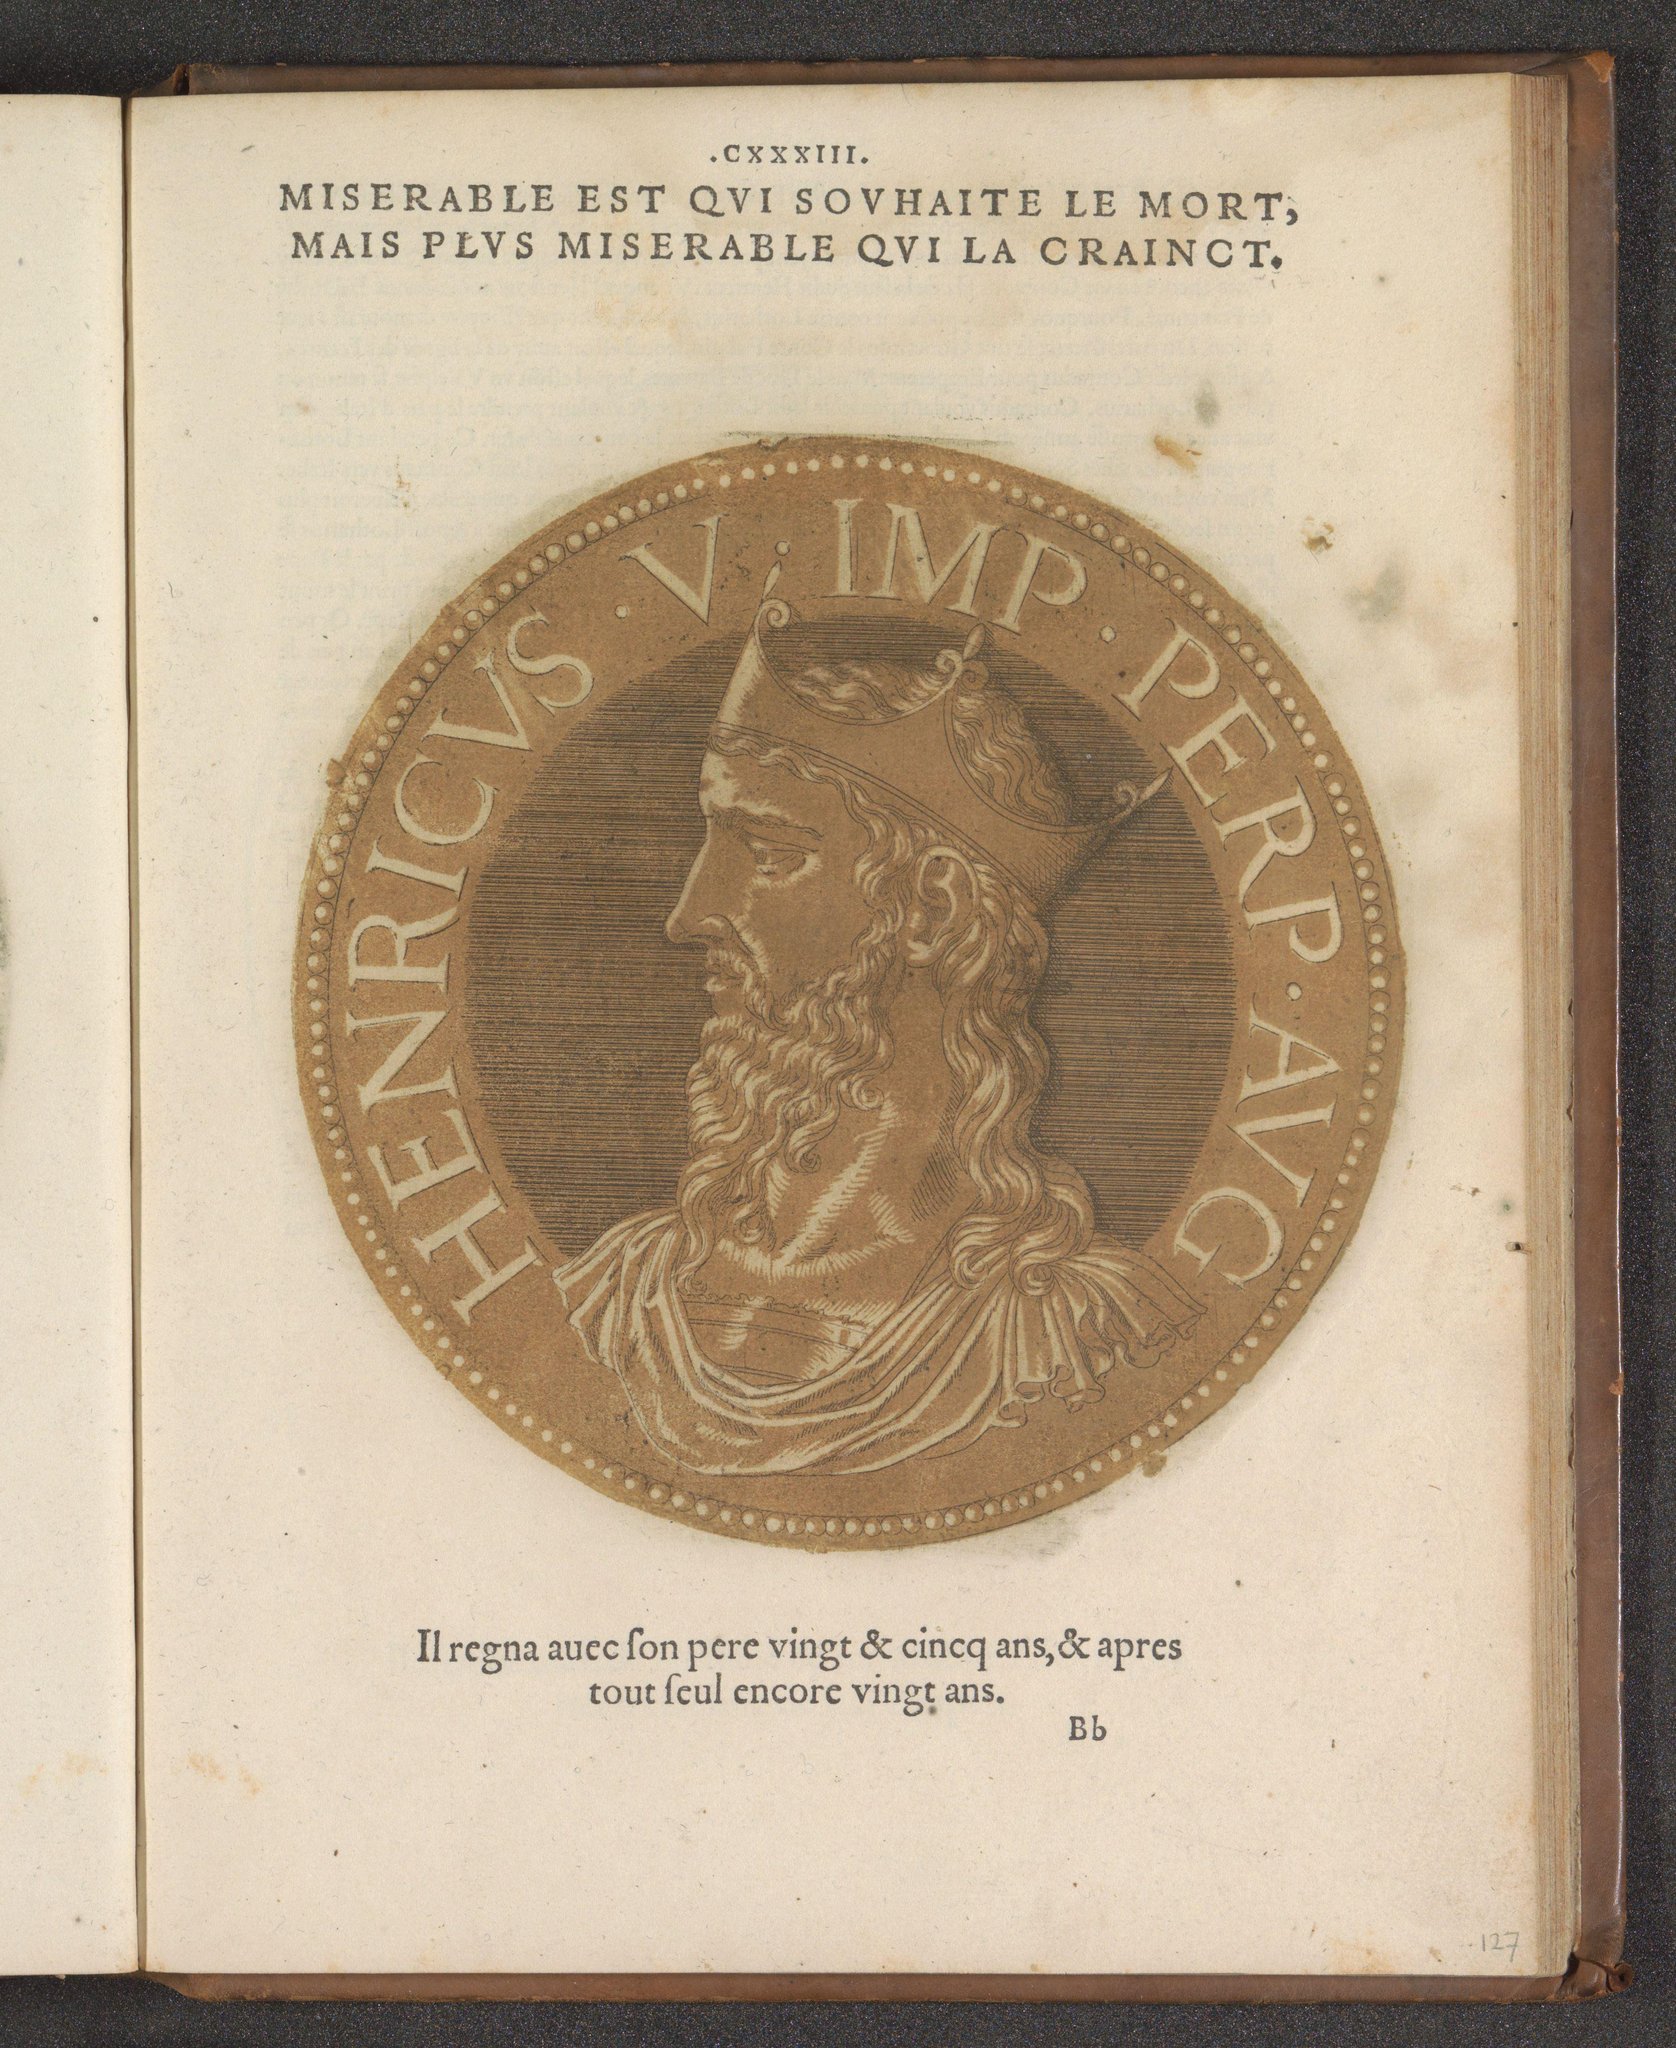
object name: page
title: Portret van keizer Hendrik V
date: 1557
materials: paper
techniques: woodcut, etching, letterpress printing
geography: antwerp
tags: utrecht, emperor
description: Portret van keizer Hendrik V, op een munt met randschrift. De prent maakt deel uit van een boek over de keizers vanaf Julius Caesar tot en met Karel V en zijn broer Ferdinand.